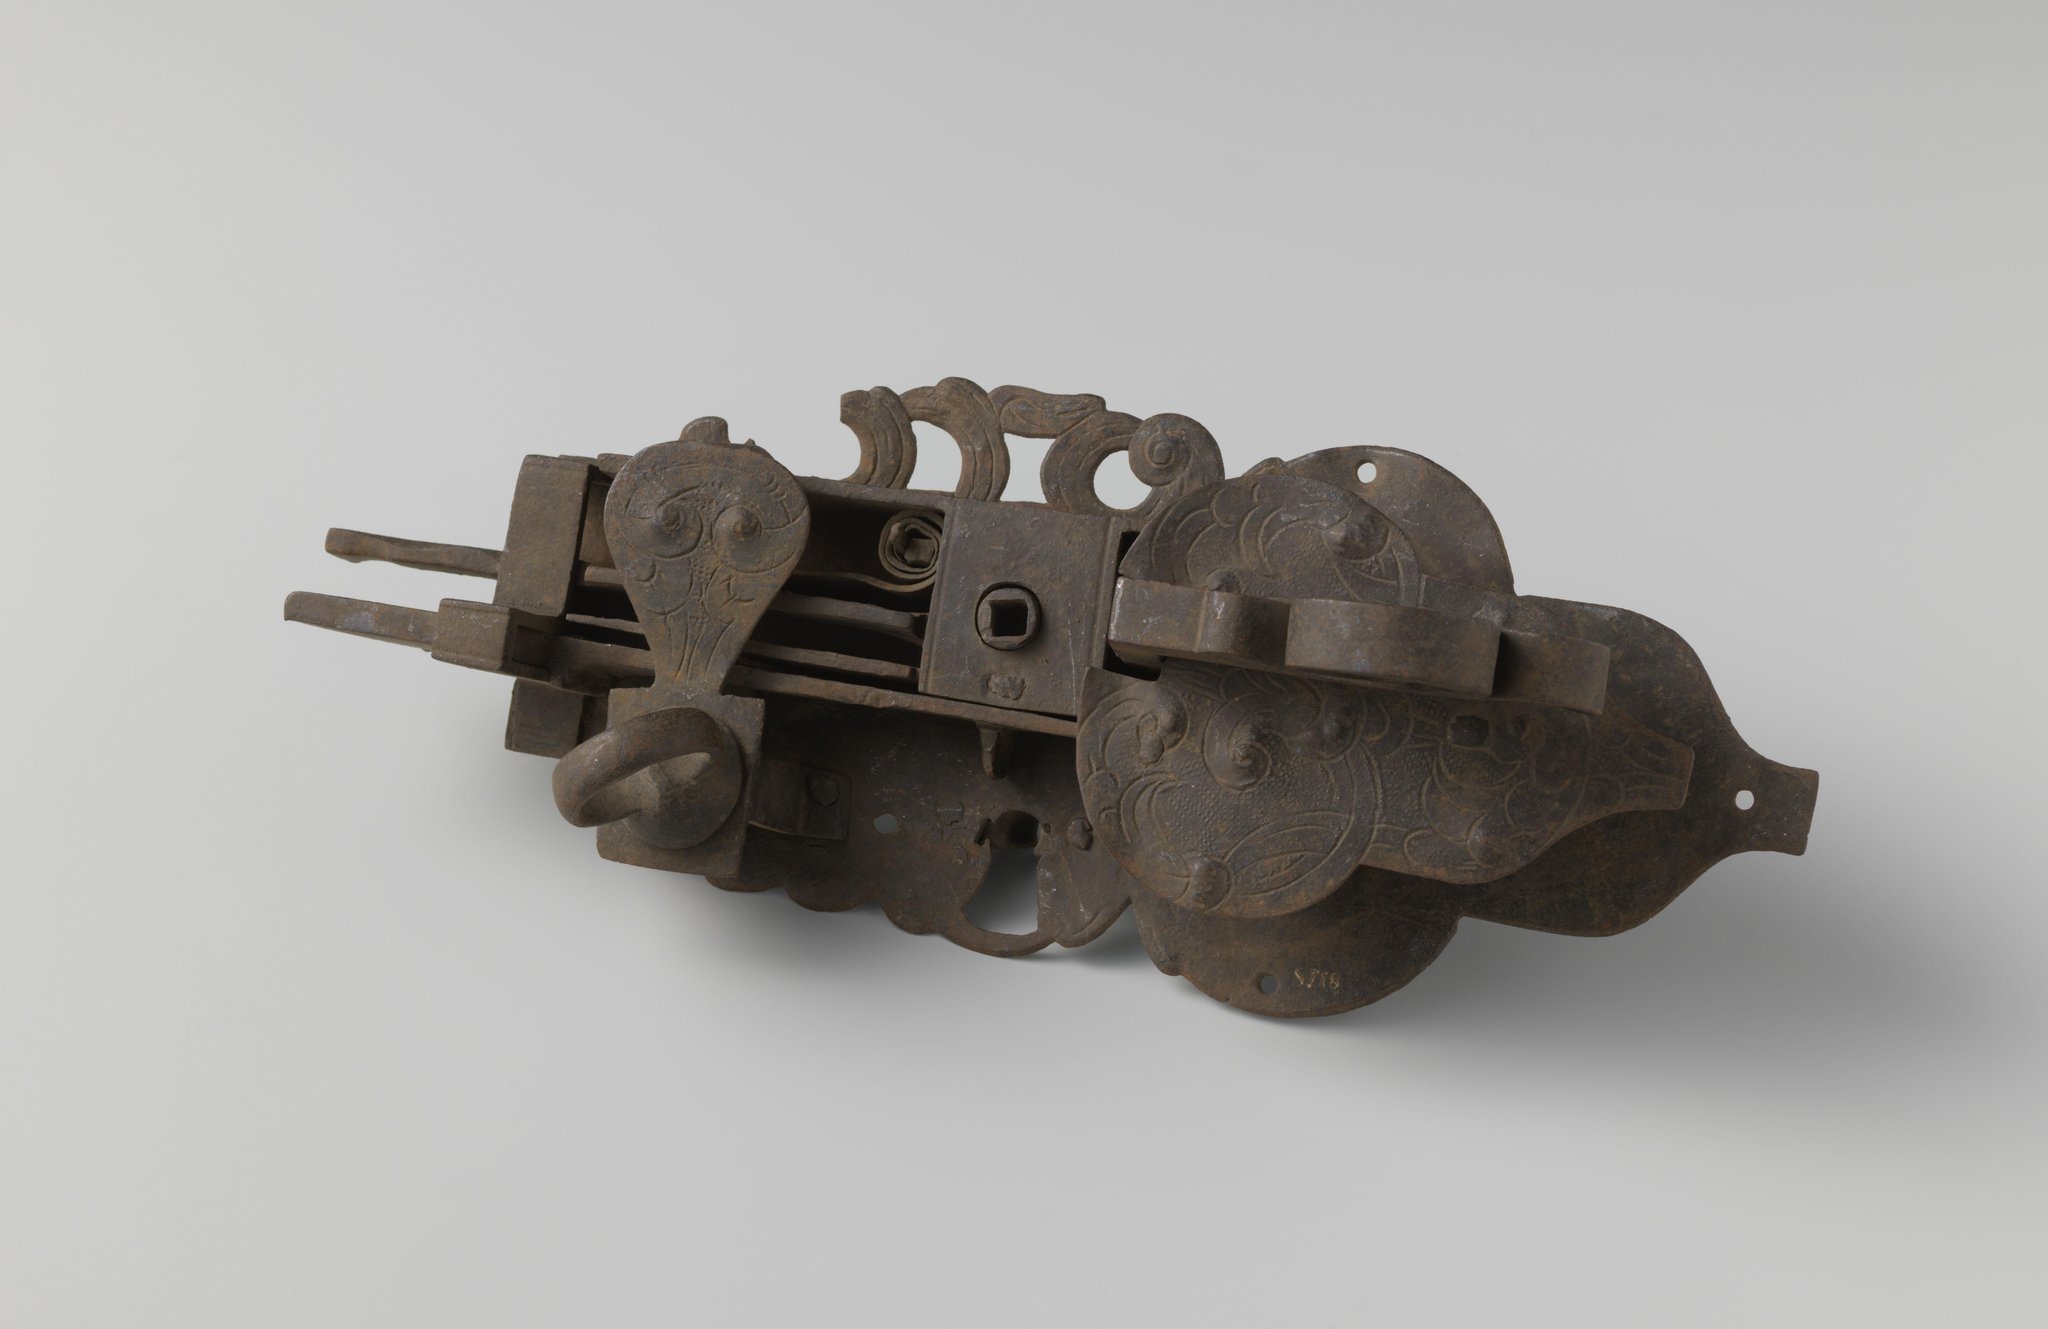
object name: lock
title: Slot van ijzer, klavervormig en met gegraveerde rankmotieven.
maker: Anonymous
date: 1600-1699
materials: iron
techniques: metalworking, engraving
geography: western europe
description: Slot van ijzer met twee schoten. De slotplaat is klavervormig, deels opengewerkt aan de zijkanten en versierd met gegraveerde rankmotieven. Het sleutelgat bevindt zich aan de rechterzijde en is horizontaal geplaatst. Daaronder is een ring met draaibare schijf. Aan de bovenzijde van de slotplaat is een spiraalvormige reep, die naar voren krult.